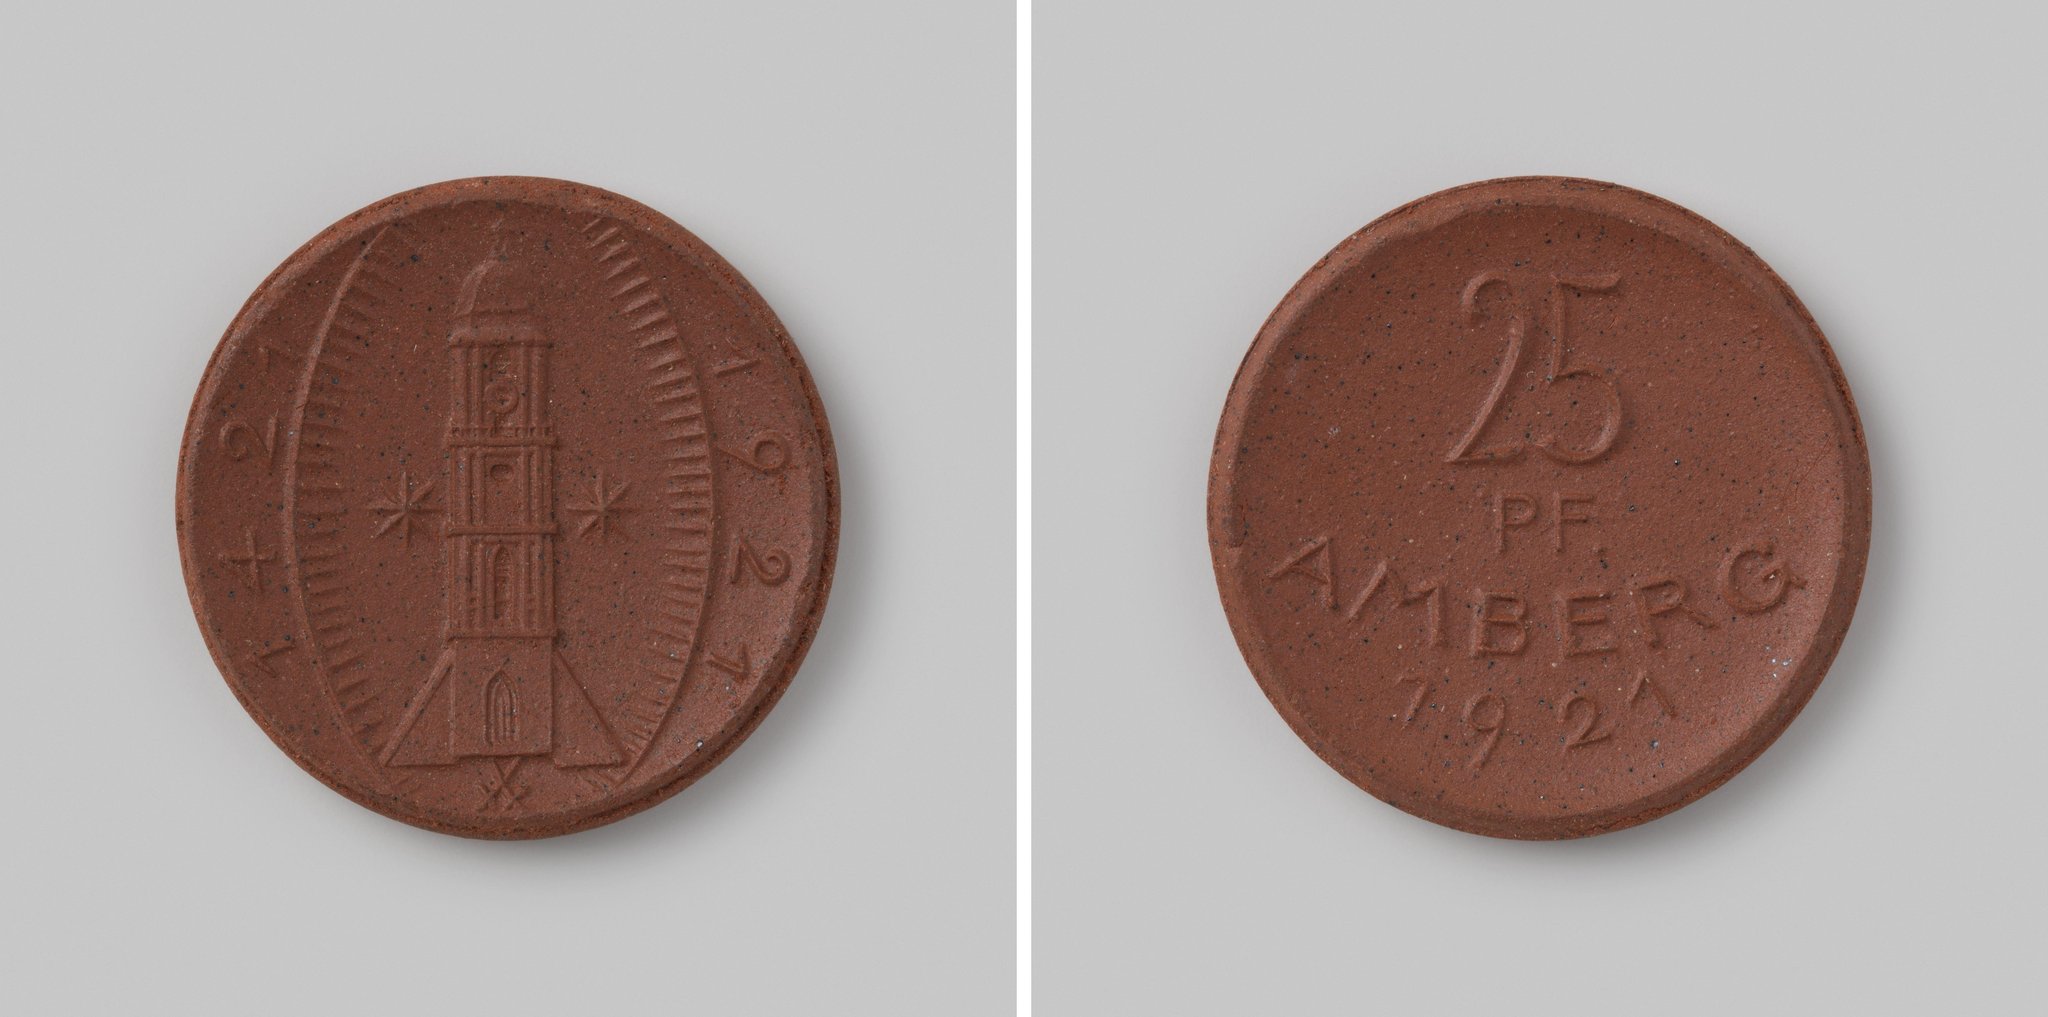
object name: coin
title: Duitsland, Amberg, 25 pfennig, 1921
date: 1921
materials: porcelain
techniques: casting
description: Porseleinen pseudomunt. Voorzijde: kerkgebouw, waaromheen jaartallen. Keerzijde: waarde-aanduiding in twee regels. Daaronder plaatsaanduiding, waaronder jaartal. Gladde rand.